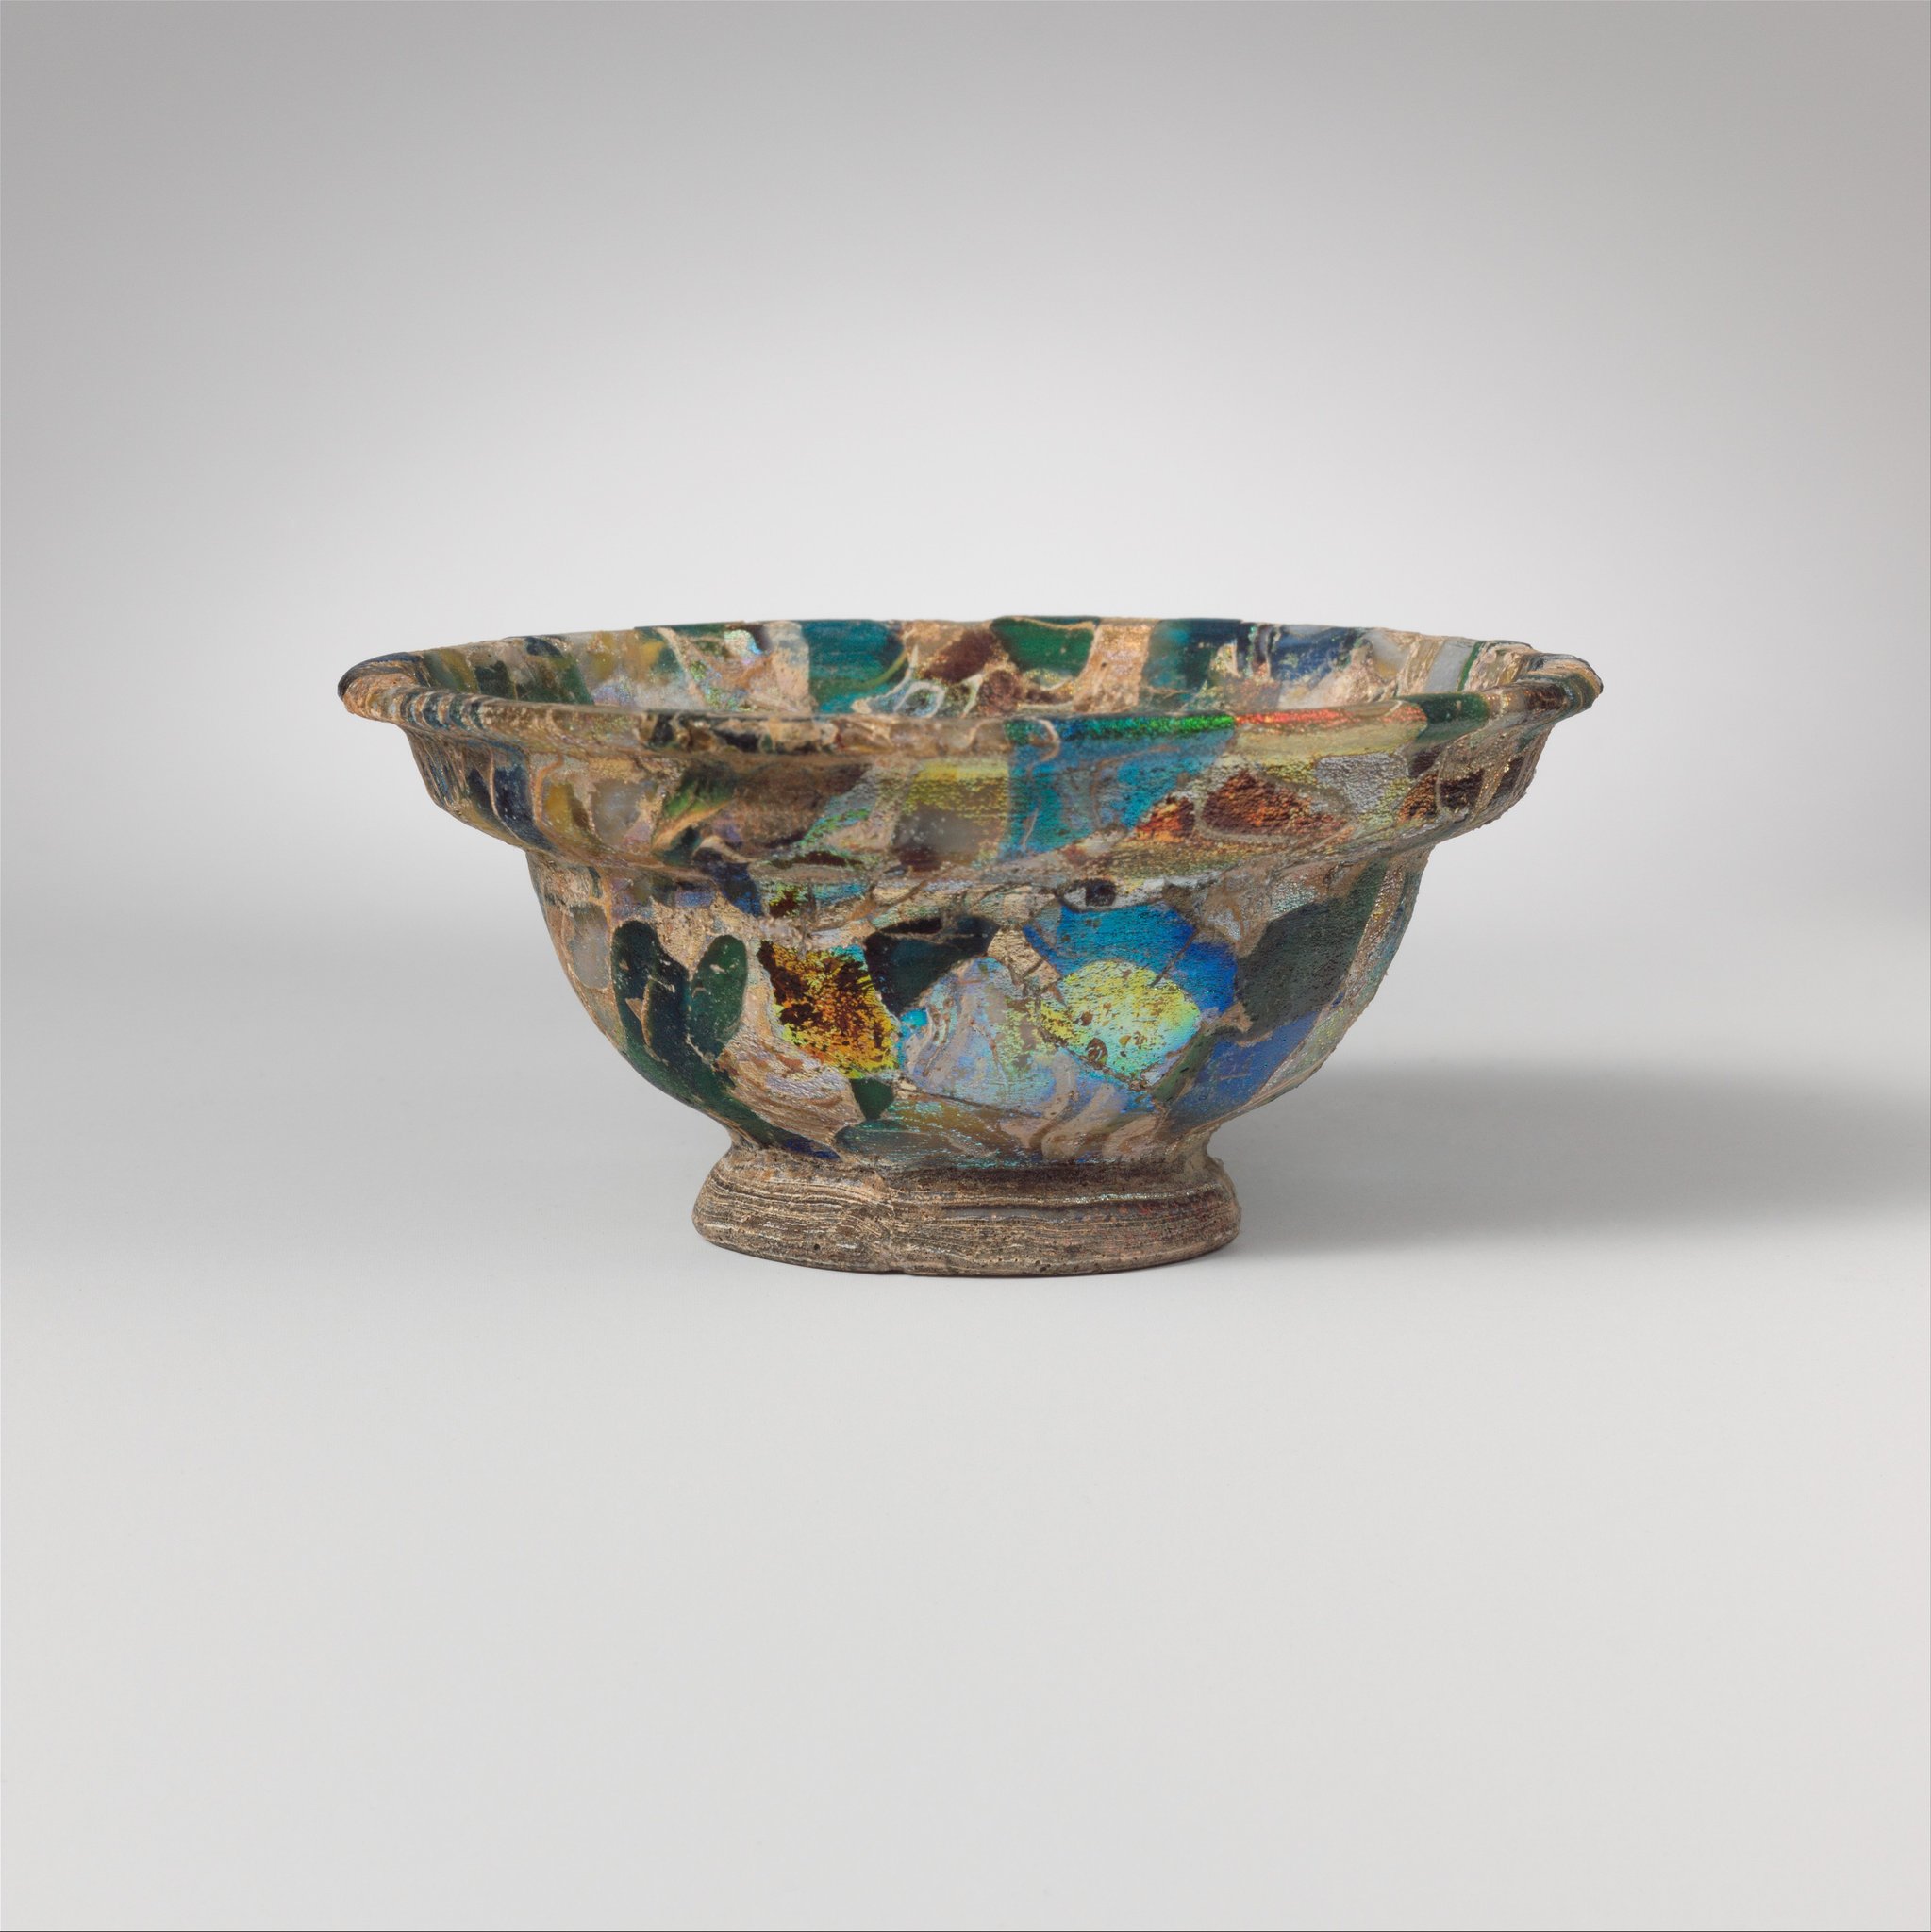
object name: bowl, mosaic, patella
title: Glass mosaic bowl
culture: roman, italian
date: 34 BCE-33 CE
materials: glass